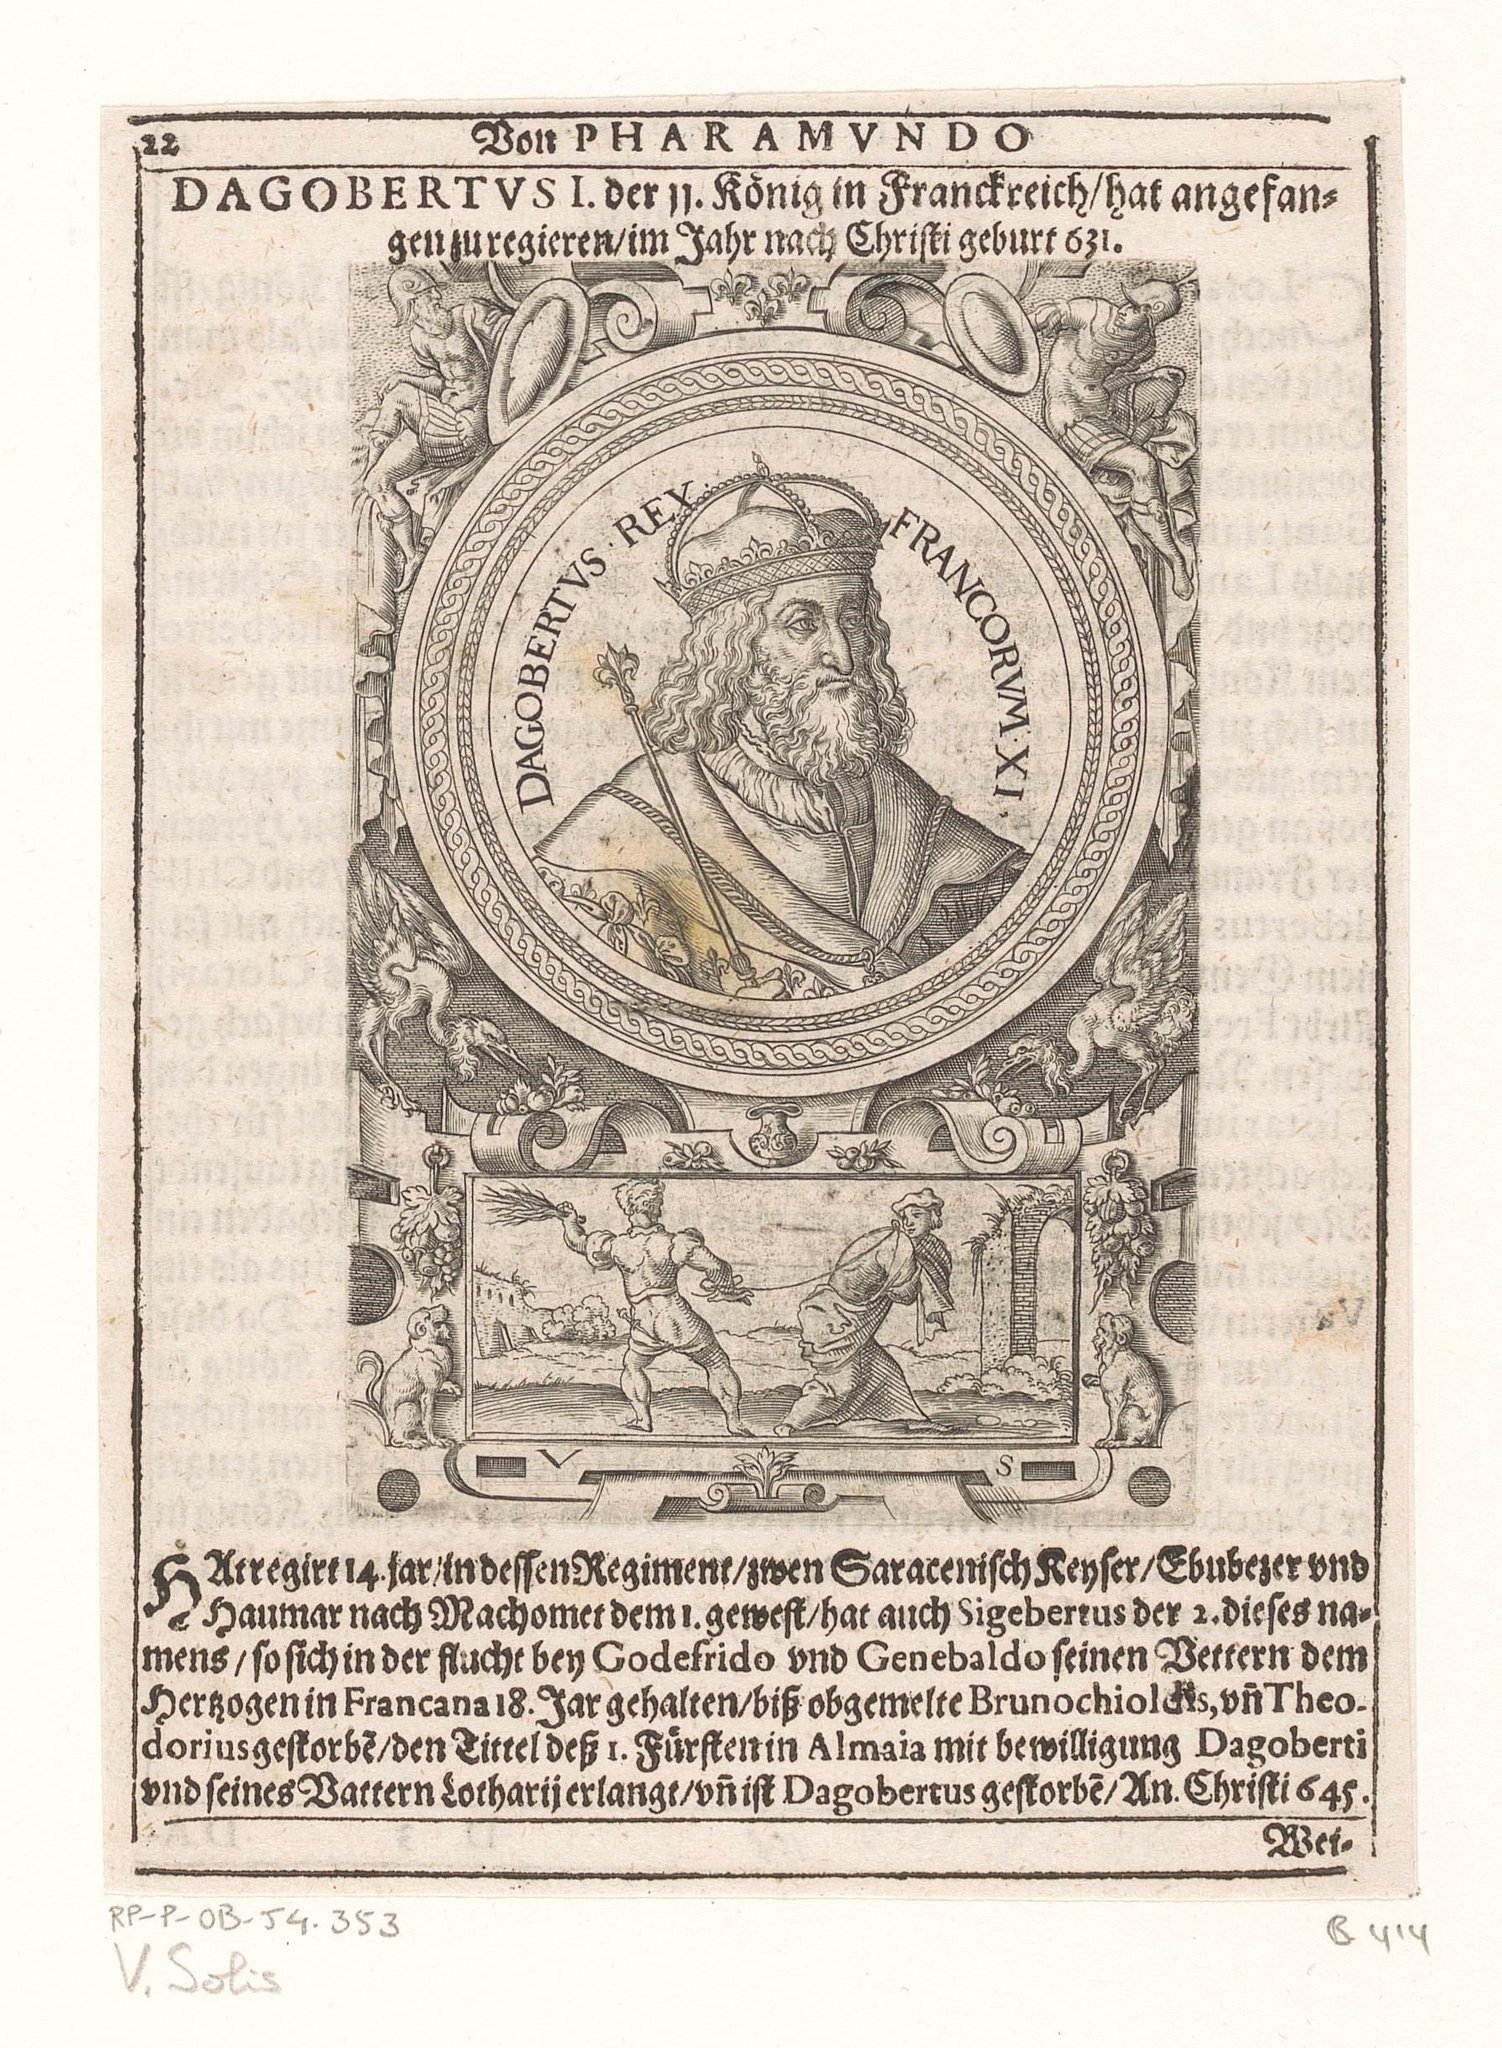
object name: book illustration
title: Portret van Dagobert I, koning der Franken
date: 1598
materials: paper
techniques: engraving, etching, intaglio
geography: nuremberg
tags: scrollwork, strapwork ~ ornament, historical persons, ruler, sovereign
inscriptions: number: ‘158’, collector's mark: Lugt 2228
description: Prent afkomstig uit de publicatie: Michael Eizinger. Könige in Frankreich. Keulen: Johann Bussemacher, 1598, p. 22. De publicatie bevat prenten van Jost Amman en Virgil Solis.